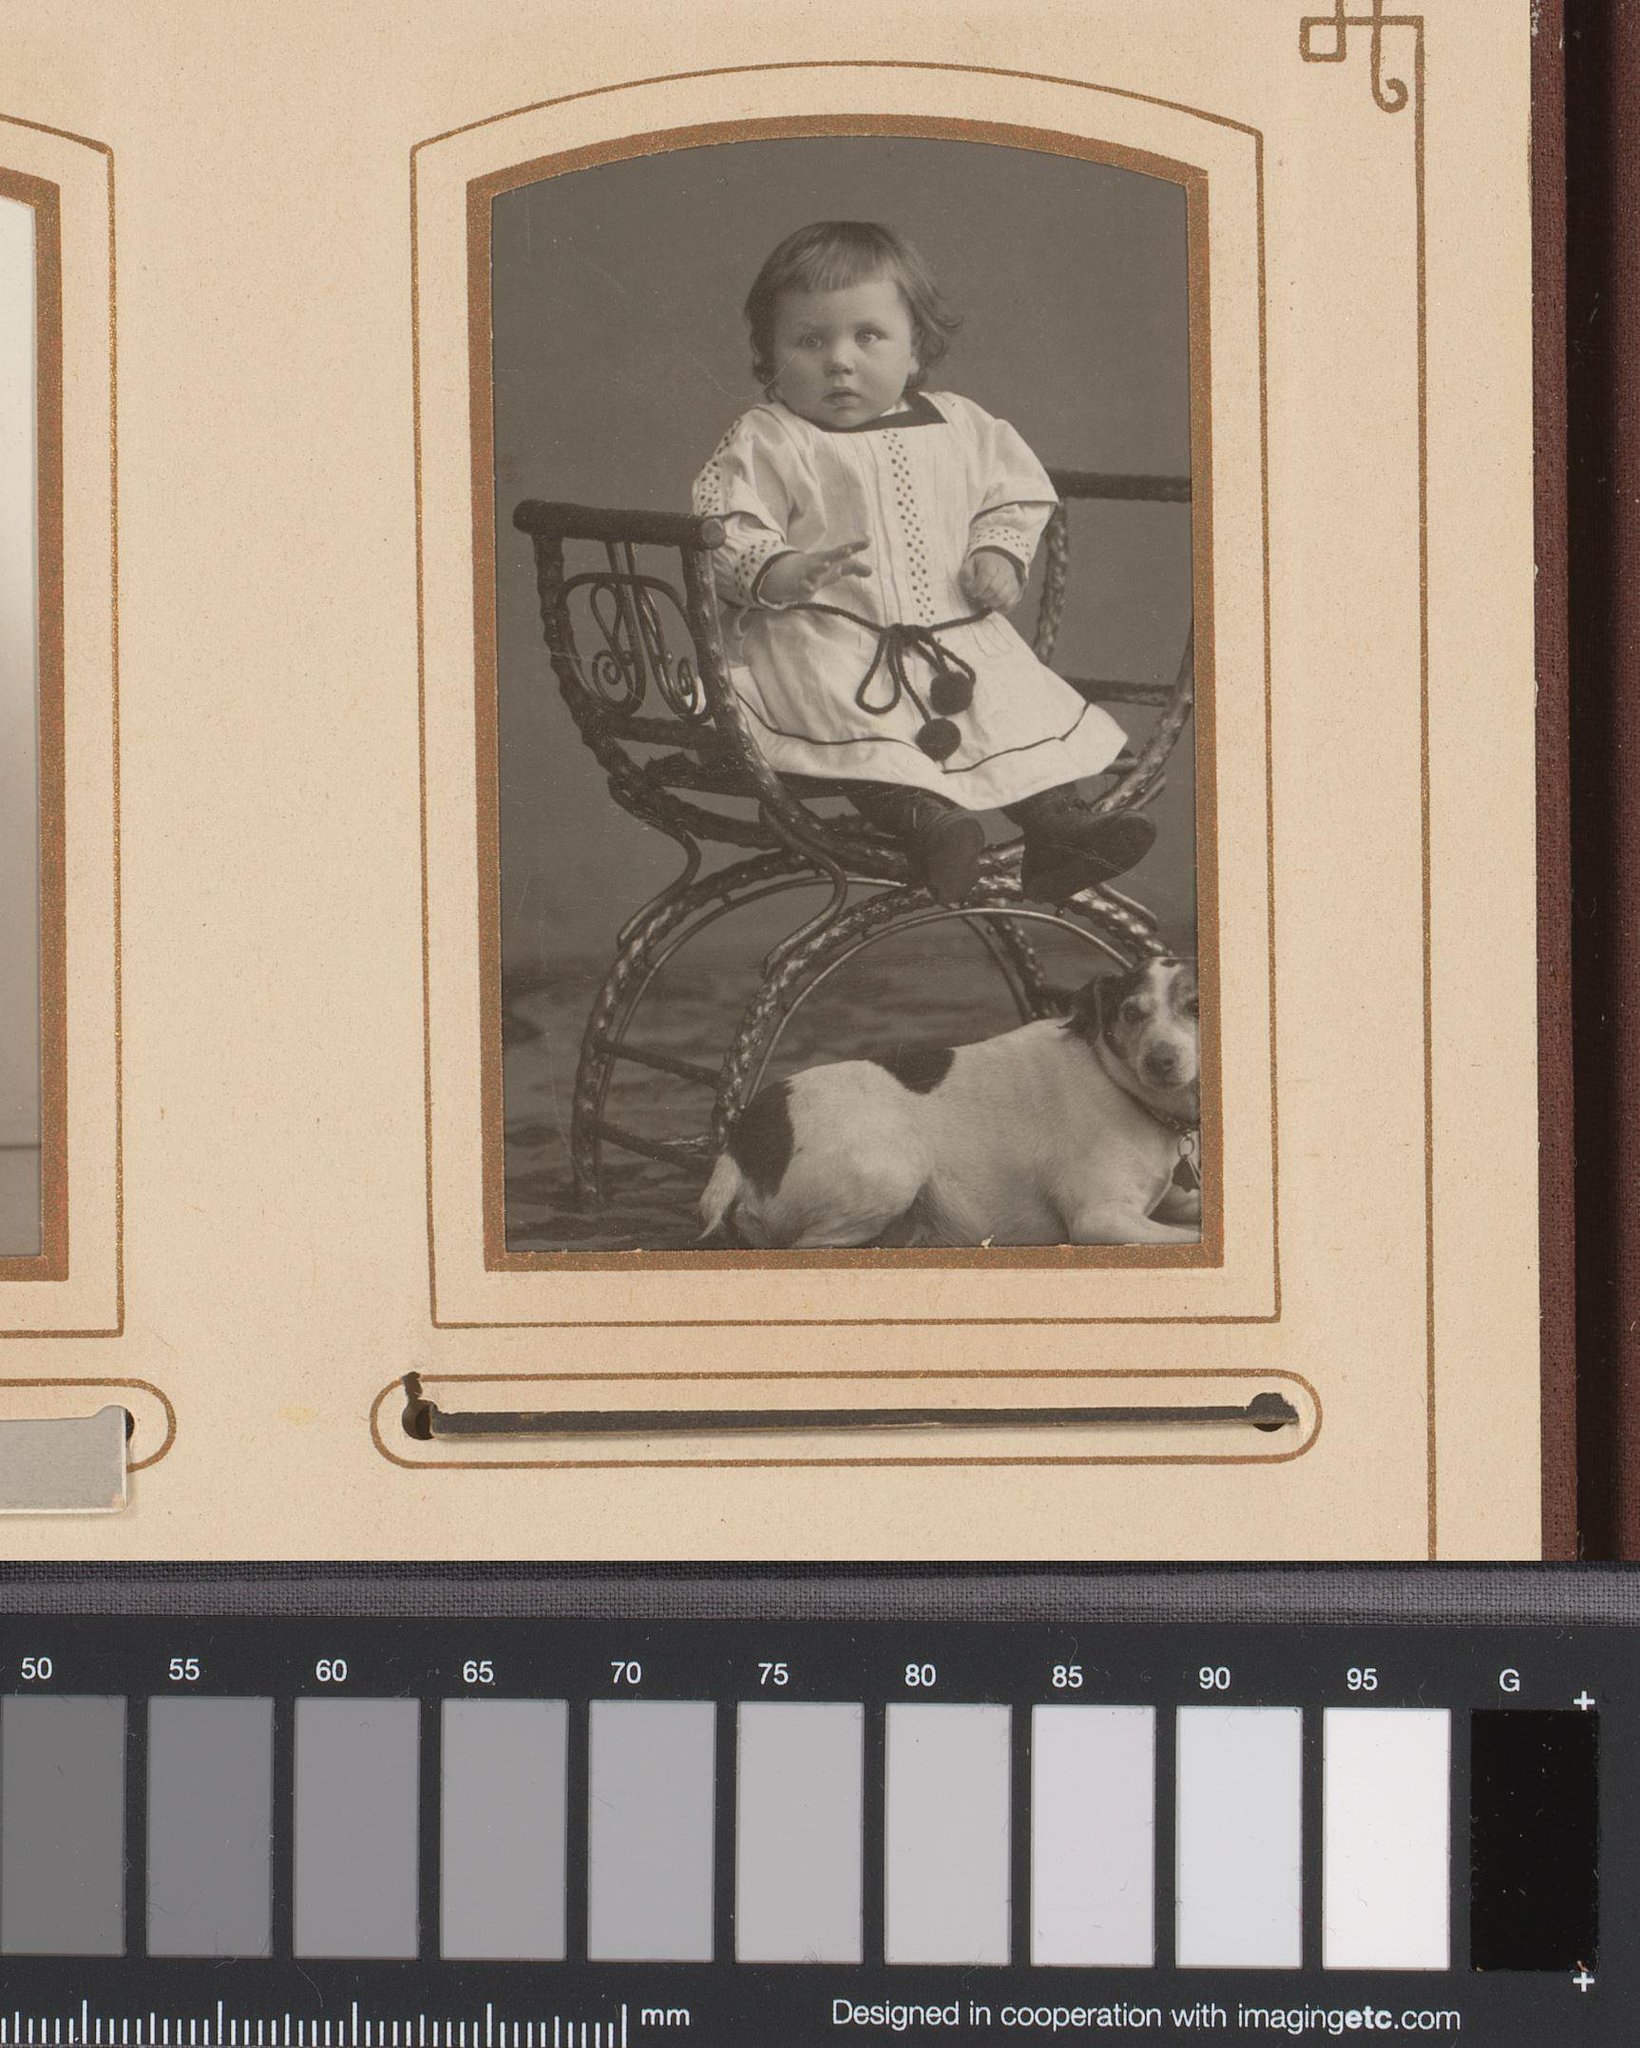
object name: photograph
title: Portret van een meisje, zittend op een stoel met hond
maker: Anonymous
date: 1880-1910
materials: cardboard, photographic support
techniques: collodion silver print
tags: sitting figure - aa - female human figure, girl (child between toddler and youth), dog